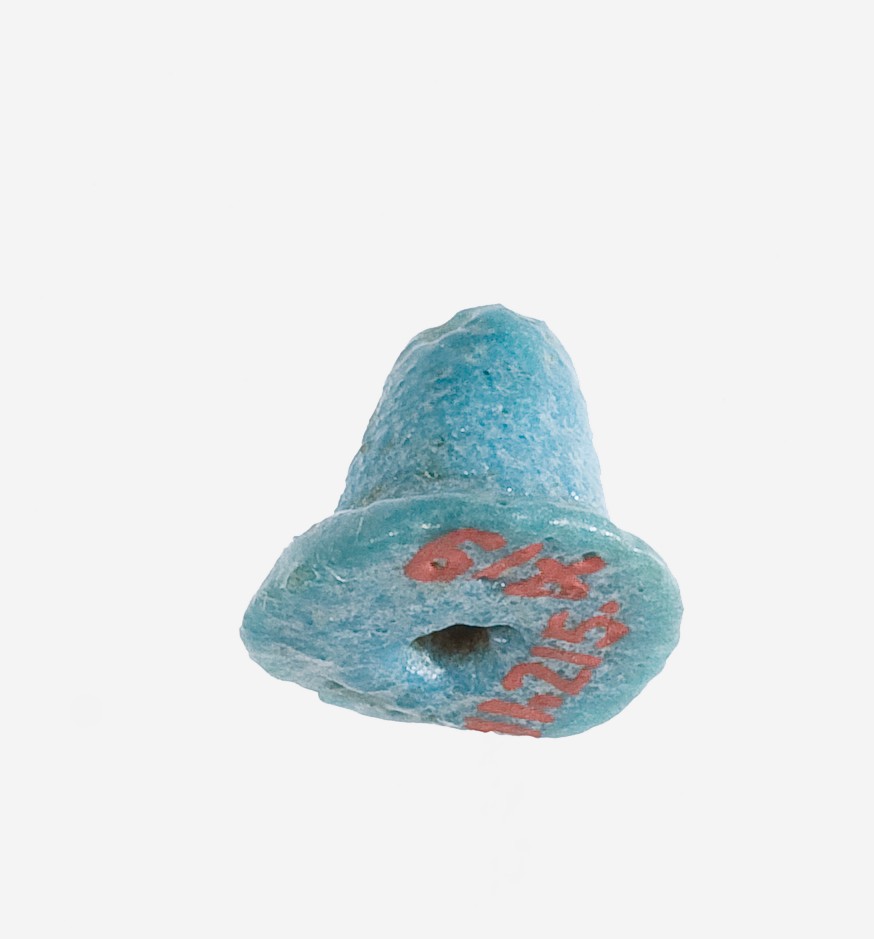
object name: pendant, umbel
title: Umbel Pendant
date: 1390-1352 BCE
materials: faience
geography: egypt